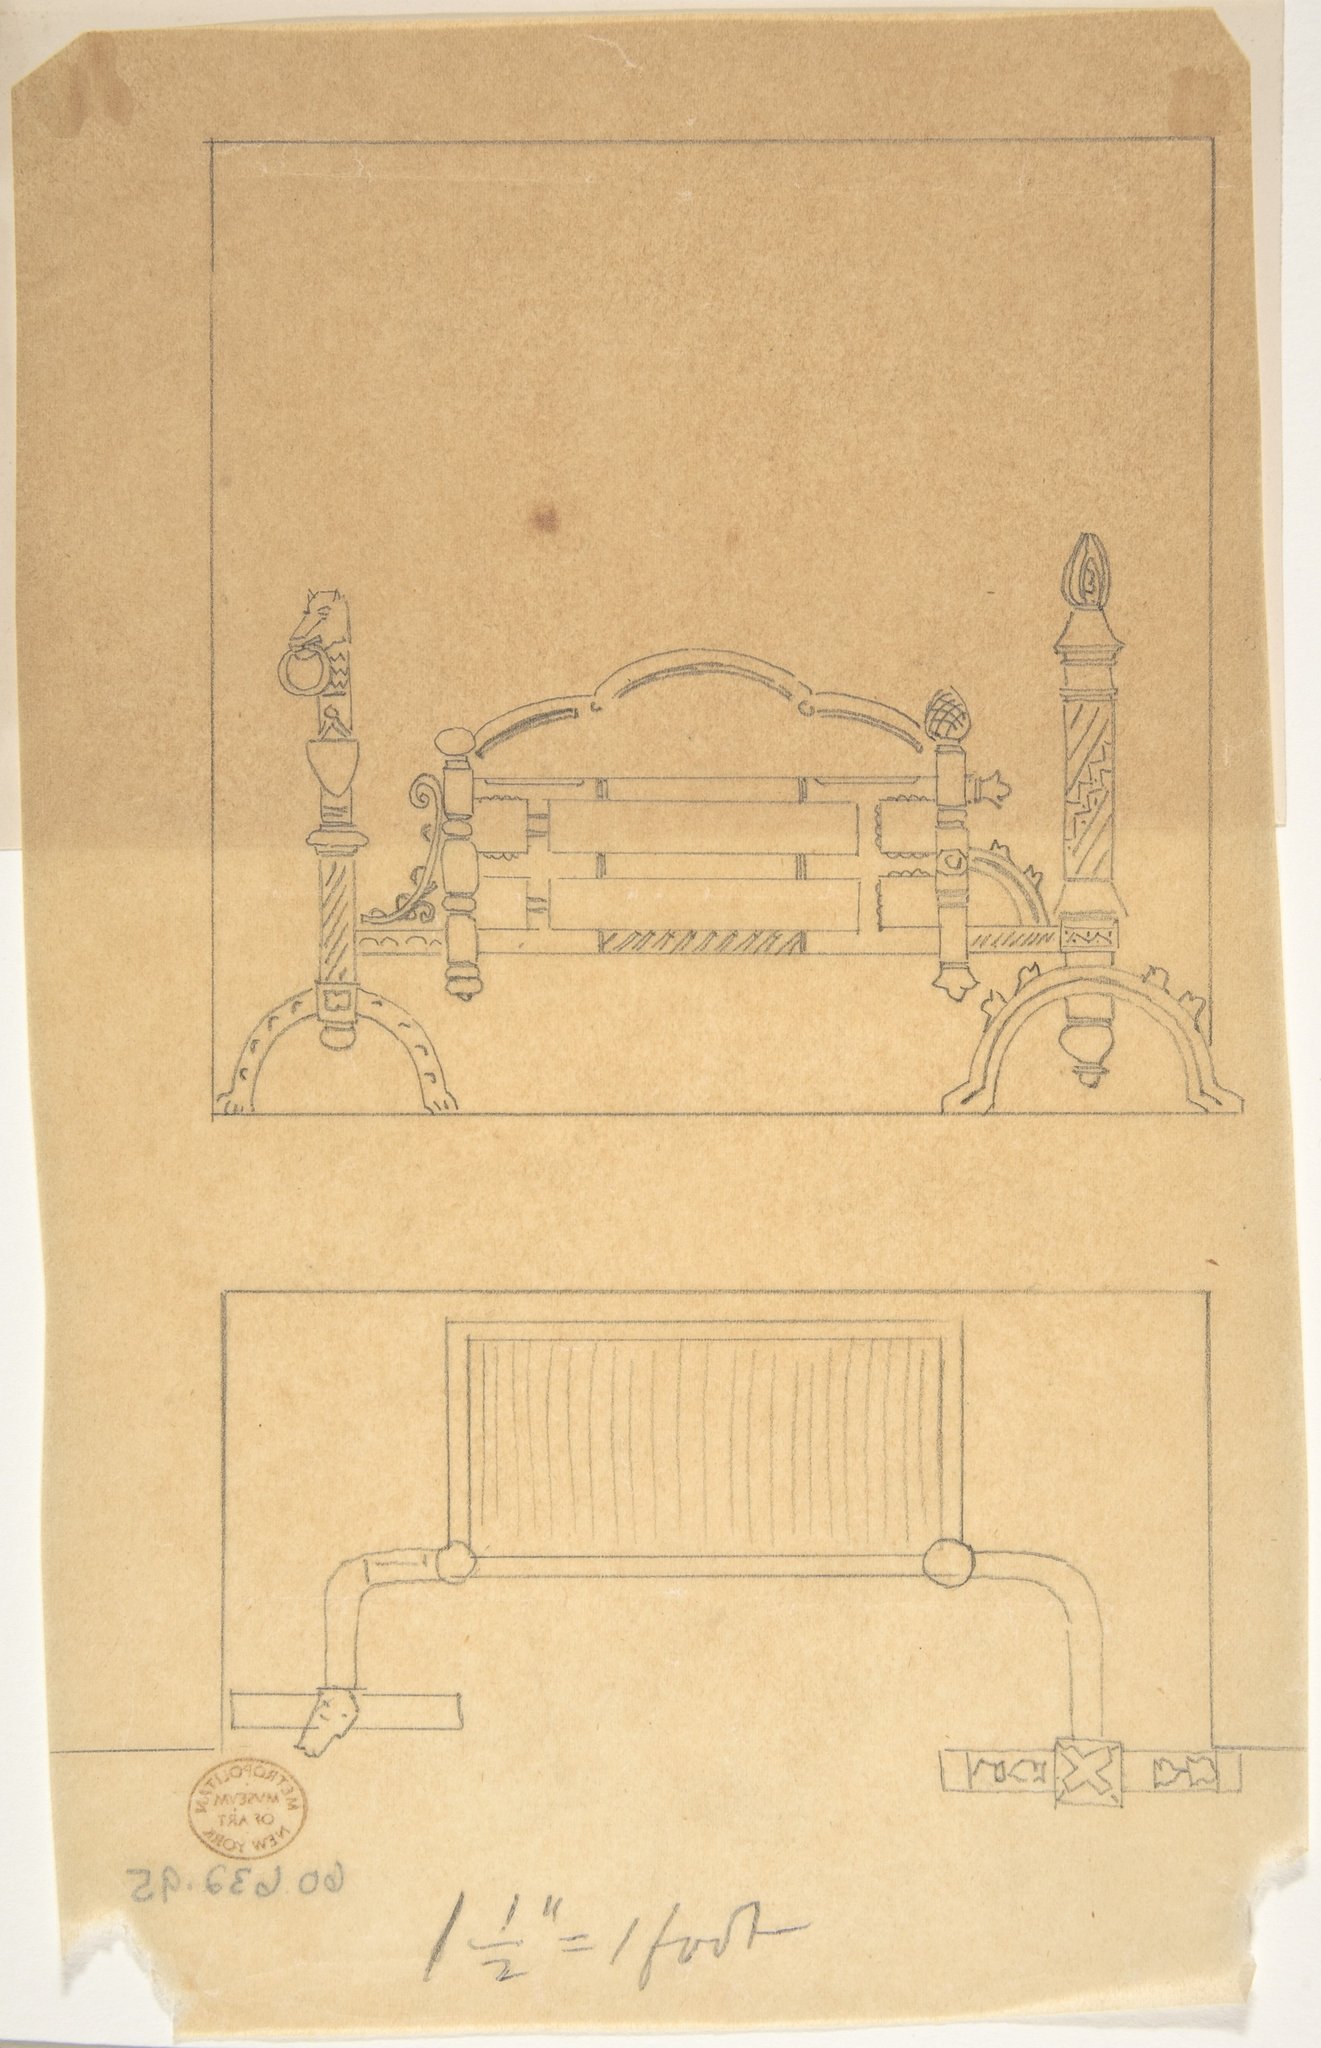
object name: drawing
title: Design for Grate, with Plan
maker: anonymous, british, 19th century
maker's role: artist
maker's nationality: british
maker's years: 1800-1900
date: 1801-1900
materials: graphite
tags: architecture